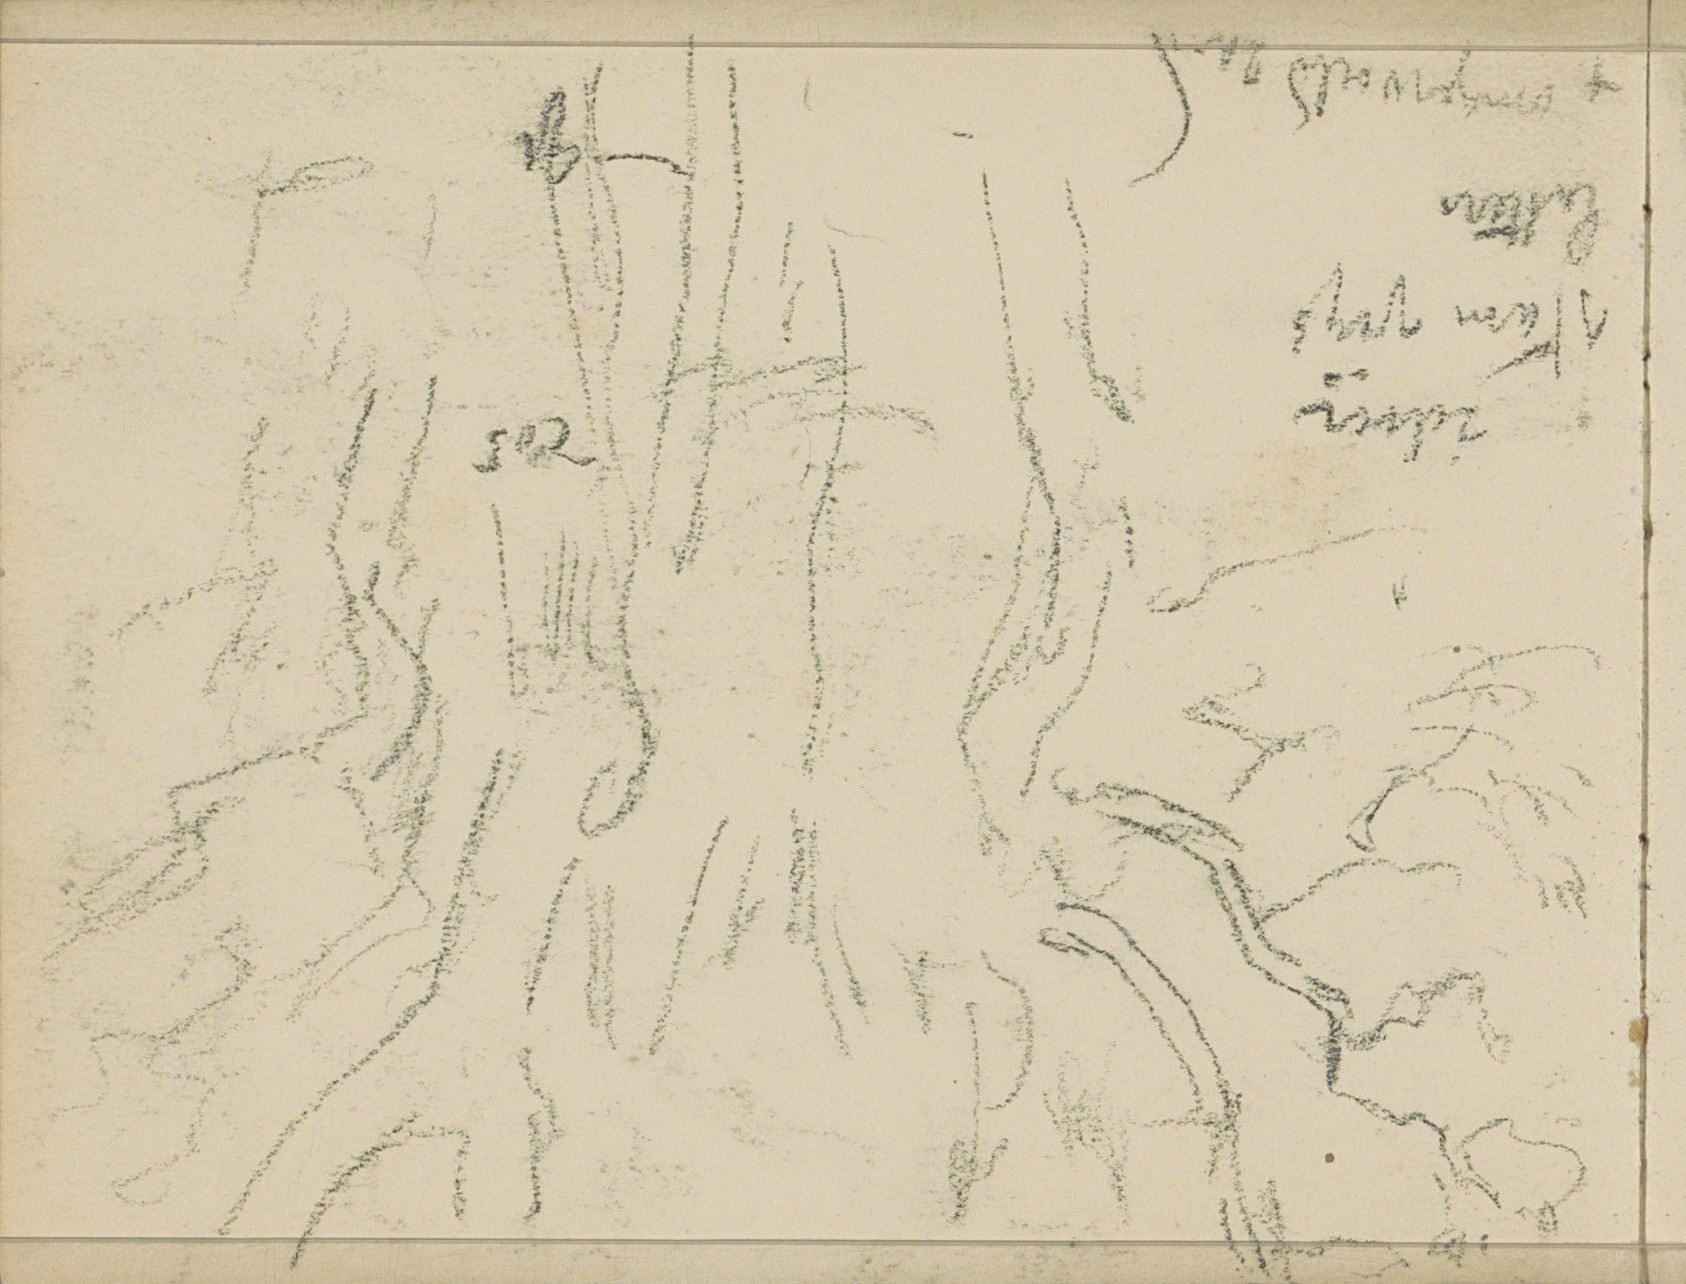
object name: sketchbook leaf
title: Bomen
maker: johan antonie de jonge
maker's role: draughtsman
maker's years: 1864-1927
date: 1881-1927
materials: chalk, paper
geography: south holland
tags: trees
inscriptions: annotation: ‘omgewoeld zand’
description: Bomen. Blad 15 verso uit een schetsboek met 34 bladen.